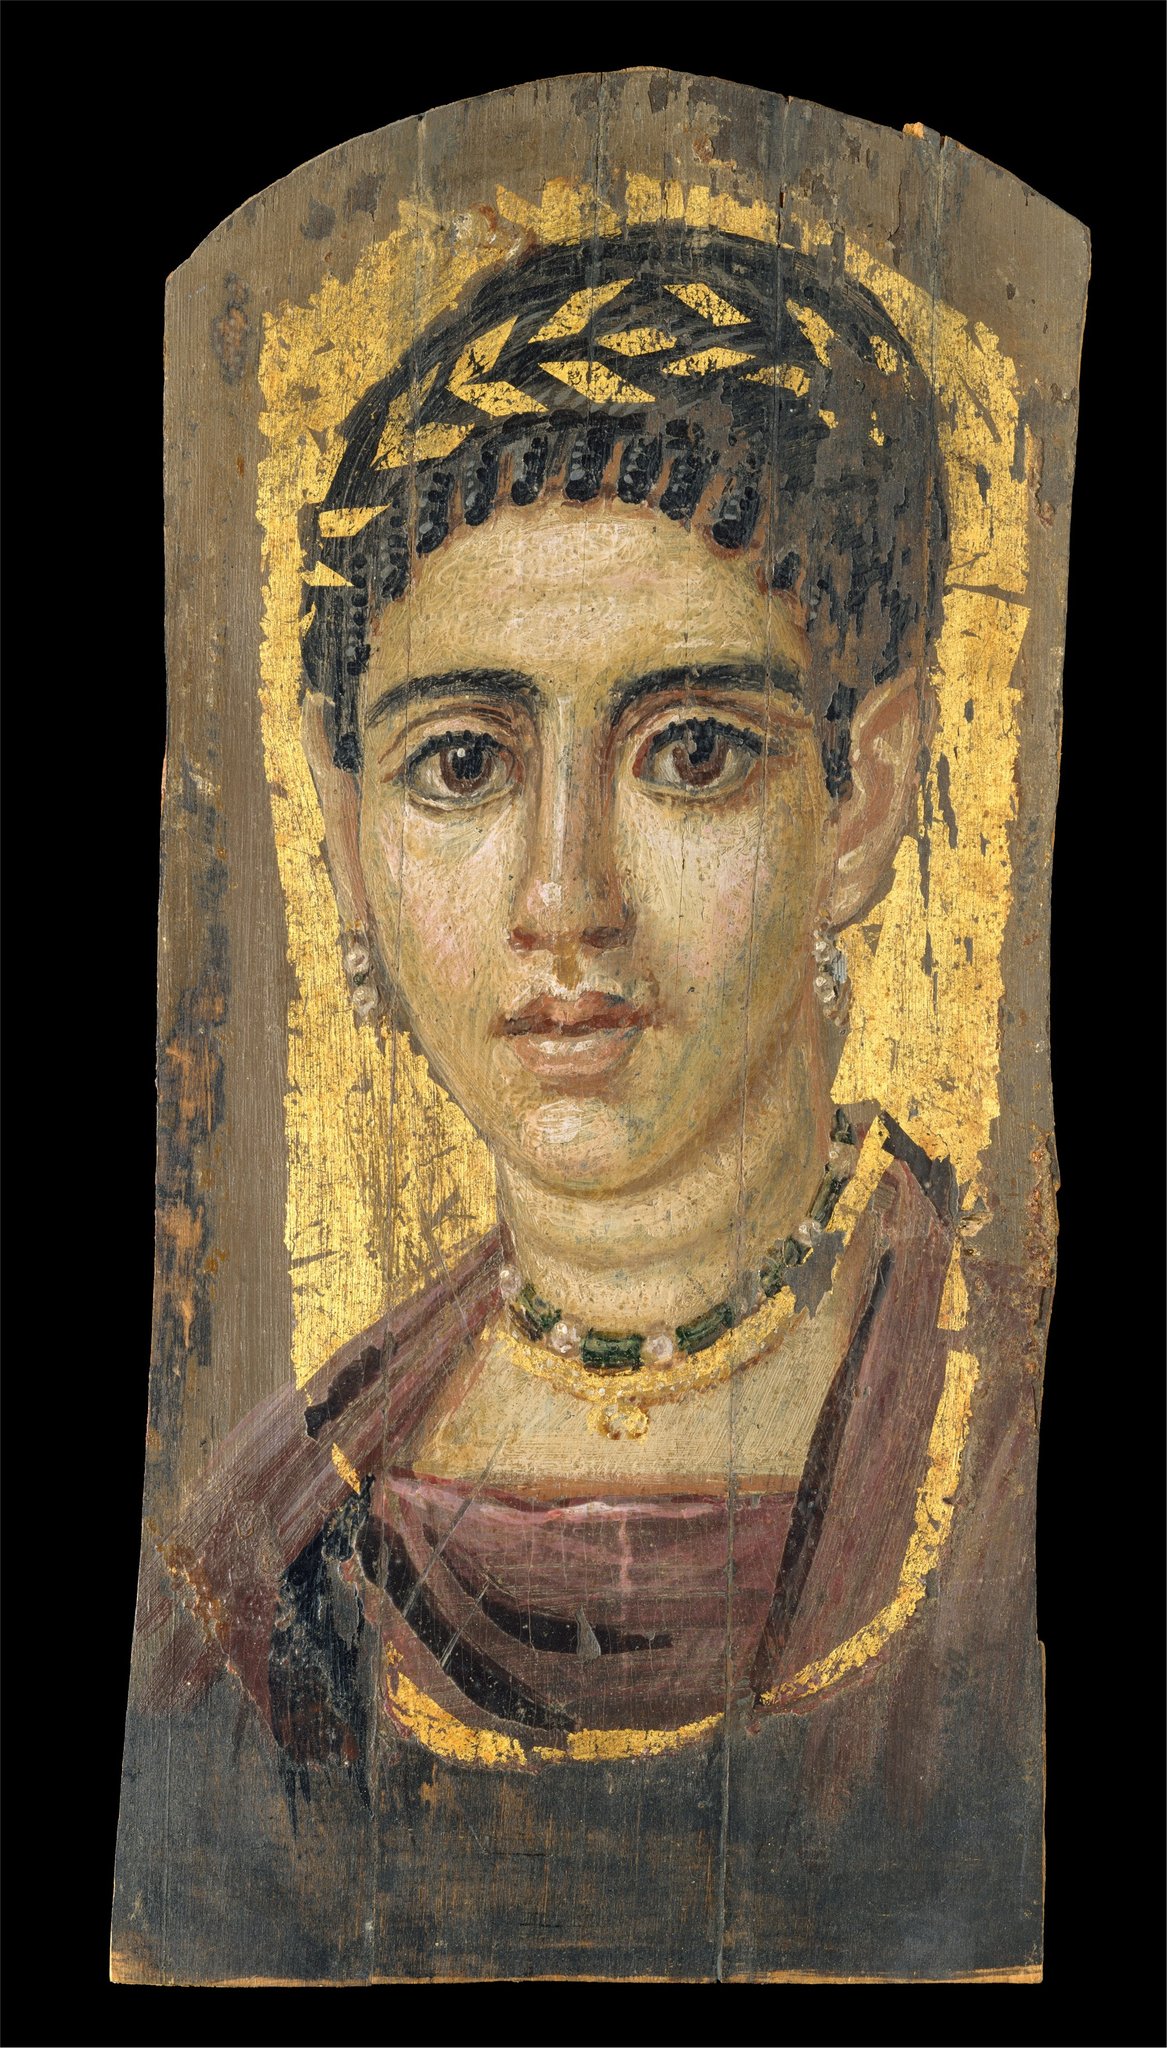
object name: panel painting, young woman, gilded wreath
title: Portrait of a young woman with a gilded wreath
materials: gold leaf, wood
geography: egypt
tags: portraits,women,wreaths